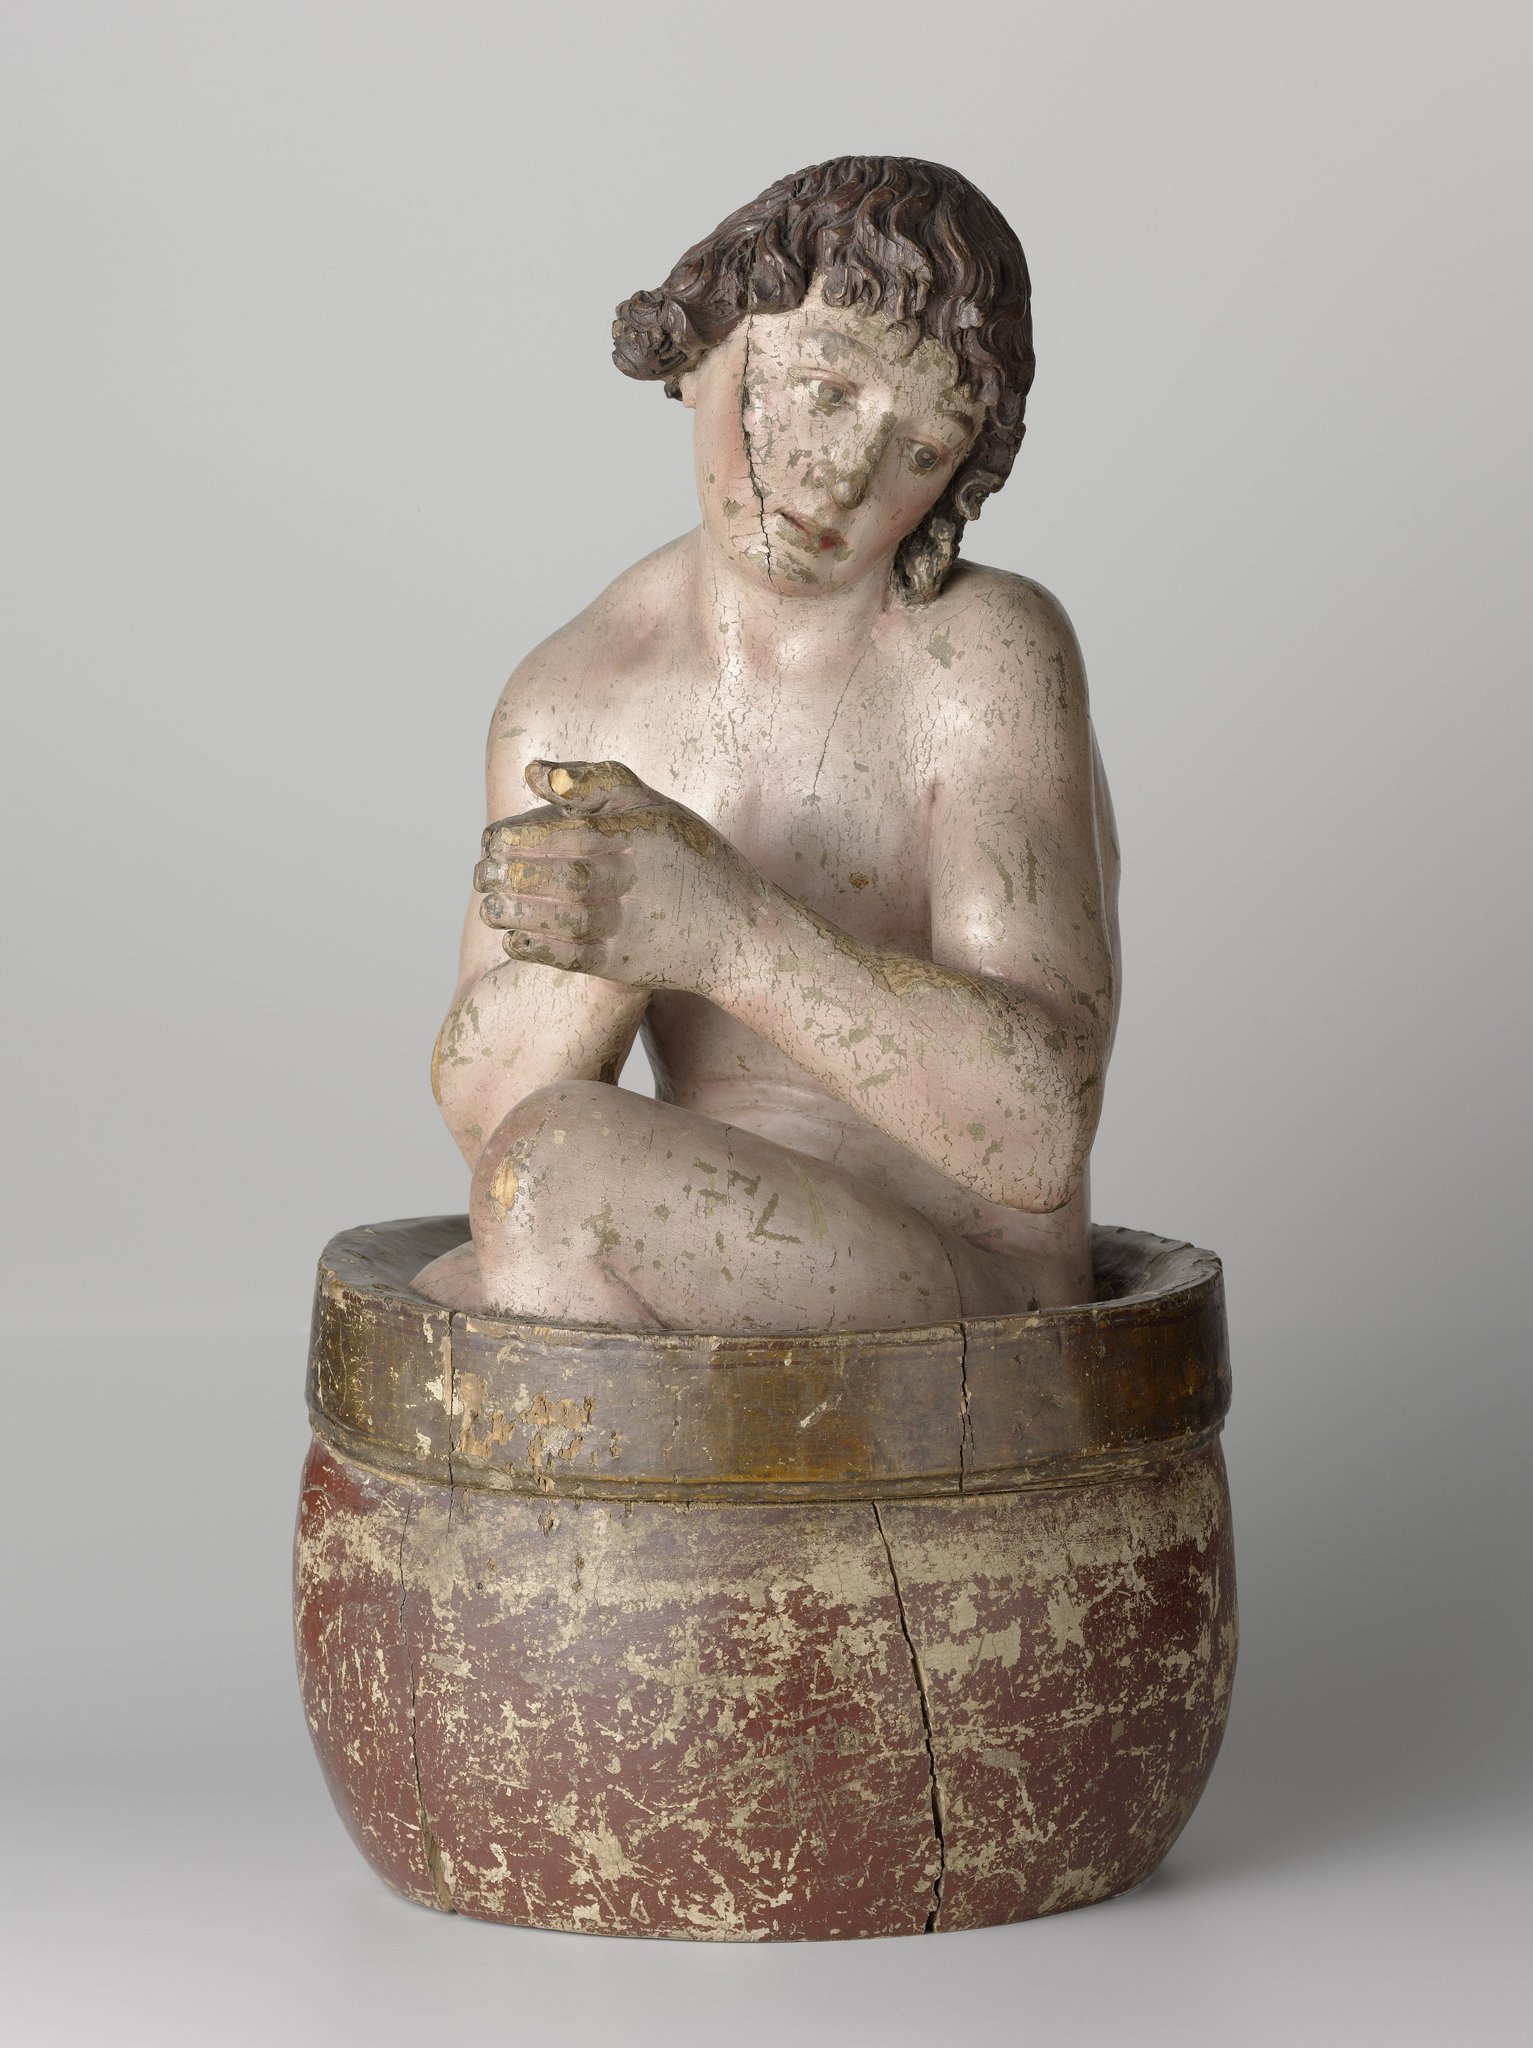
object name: figure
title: Saint Vitus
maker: Anonymous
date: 1500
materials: wood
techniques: polychromy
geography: ulm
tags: st. vitus (perhaps together with modestus and crescentia) is put in a cauldron of boiling oil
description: Vitus was a 4th-century Sicilian boy who endured barbaric forms of torture after his conversion to Christianity. The cruellest of these was to be boiled, aged twelve, in a cauldron of oil, resin and pitch. Miraculously, he survived, thanks to his unwavering faith. Depicting Vitus in a cauldron was very popular during the Middle Ages, especially in southern Germany.